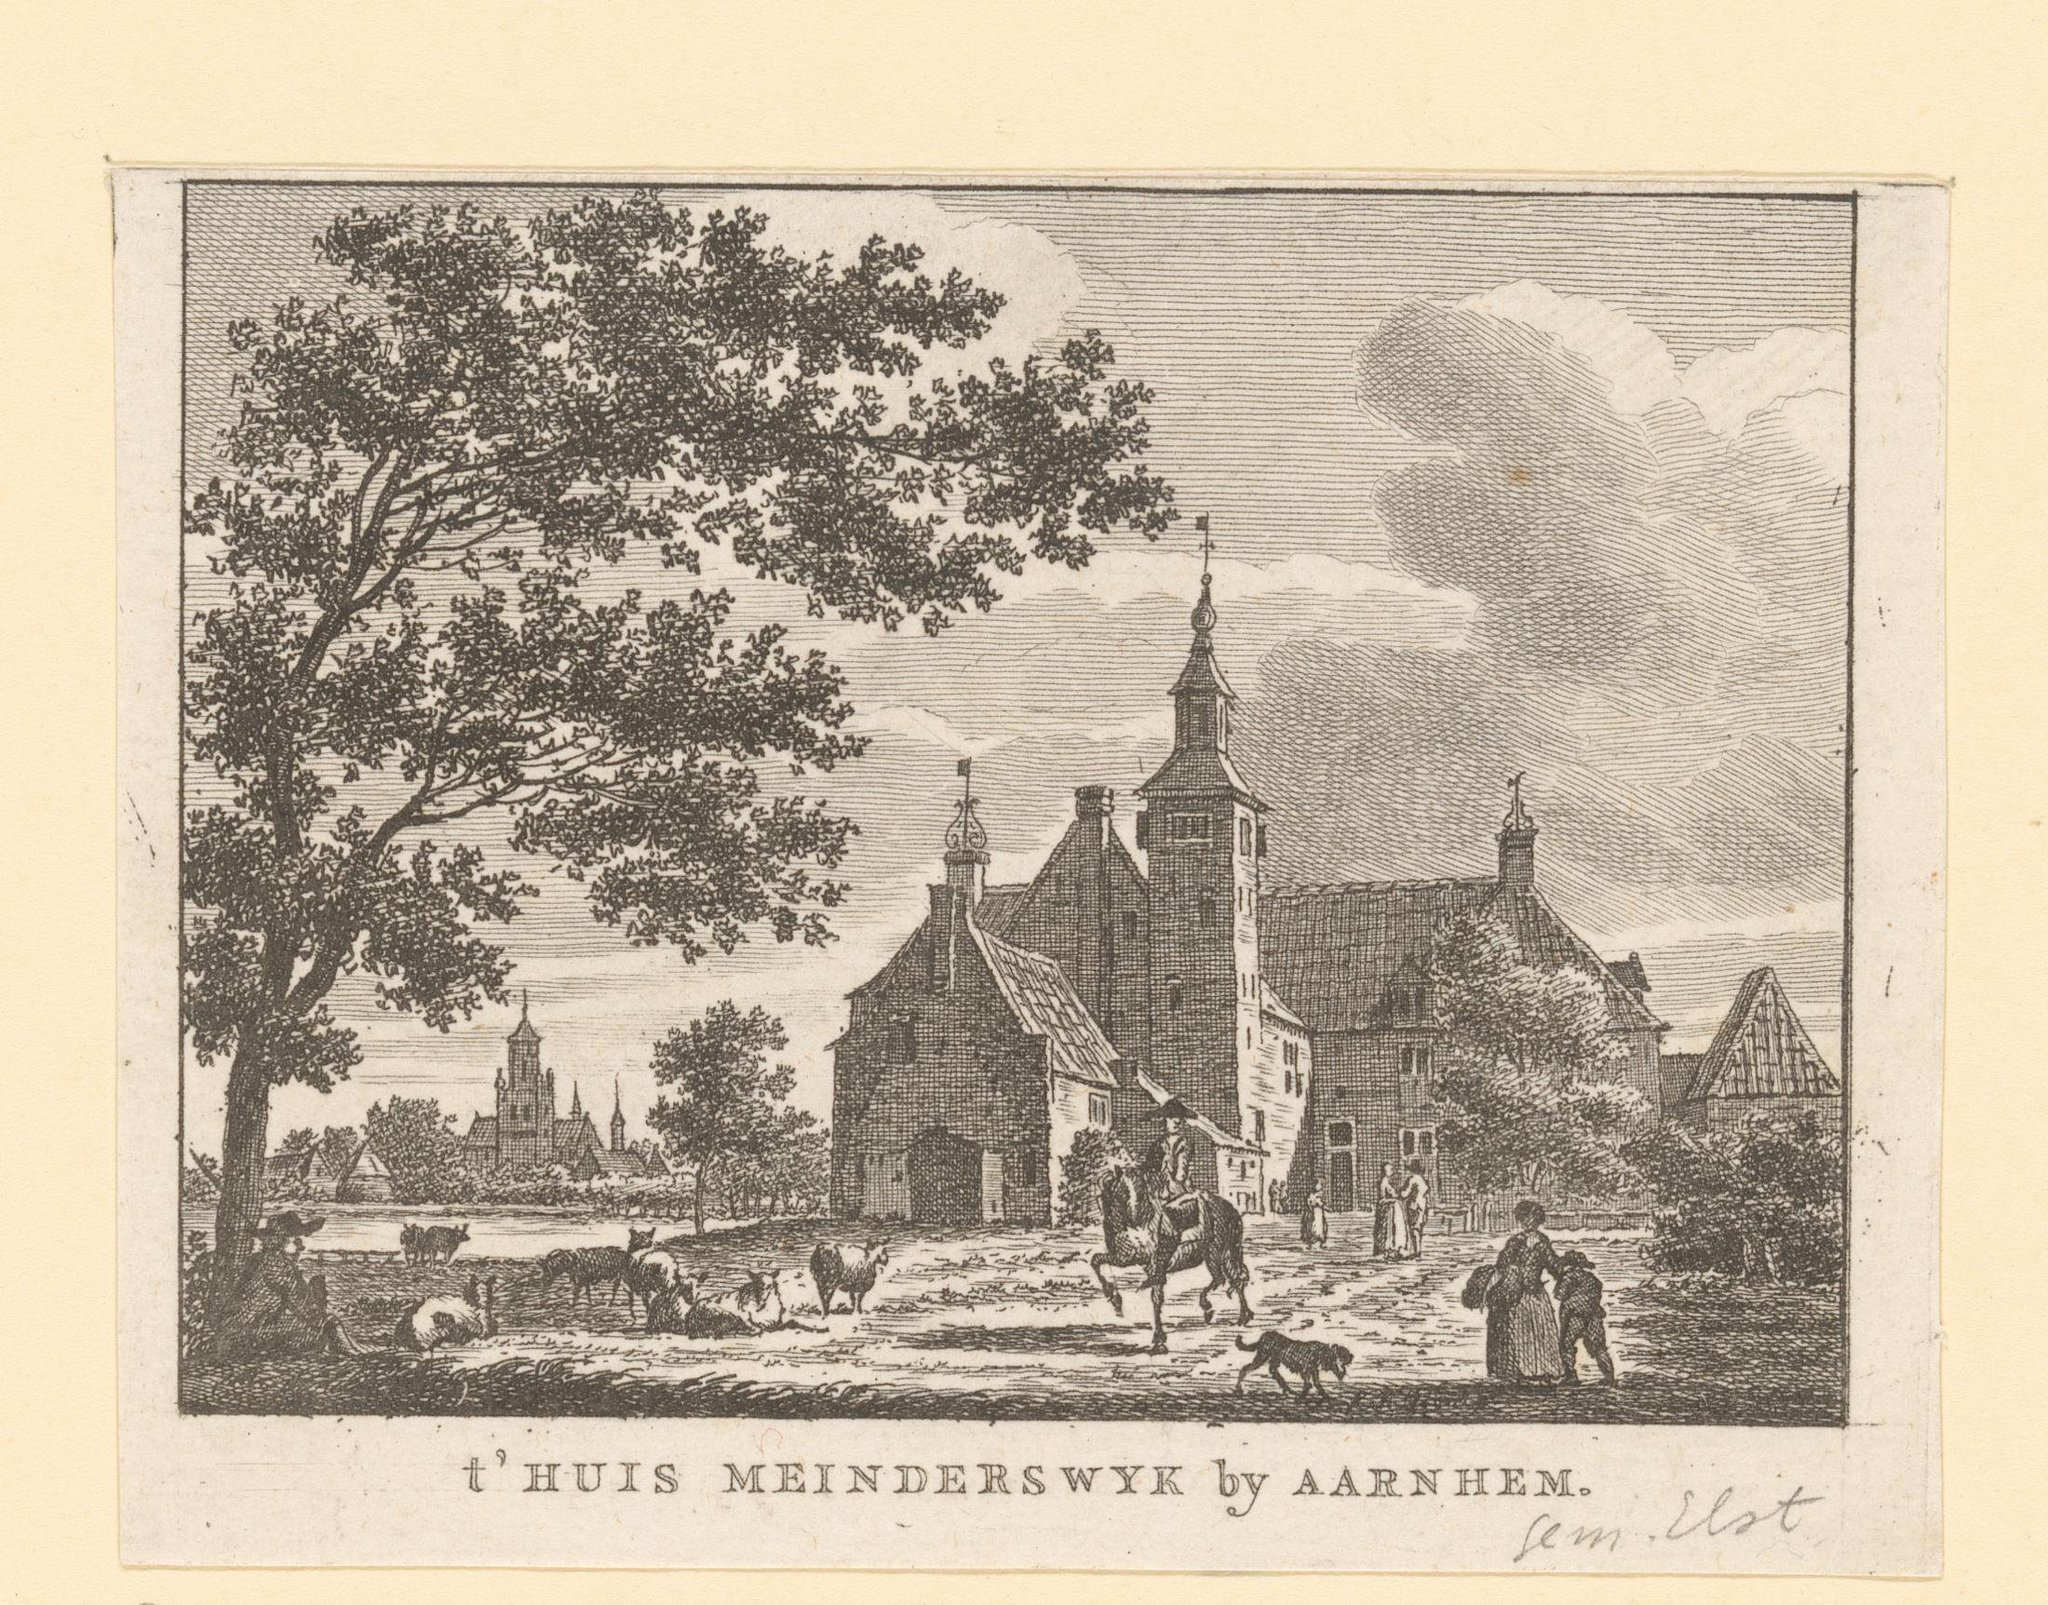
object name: print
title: Gezicht op het Huis Meinerswijk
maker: carel frederik bendorp (i)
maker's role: print maker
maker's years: 1736-1814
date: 1786-1792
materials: paper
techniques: etching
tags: castle, arnhem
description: Prent uit: Vaderlandsche gezichten, of afbeeldingen van den tegenwoordigen staat der Vereenigde Nederlanden (…). Amsterdam: Hendrik Gartman, Willem Vermandel en Jan Willem Smit, 1786-1792. Uitgegeven in afleveringen met ieder een eigen bifolium en inhoudsopgave. Alle prenten in deze publicatie zijn gegraveerd door Carel Frederik Bendorp (I) en, in de meeste gevallen, gebaseerd op tekeningen van Jan Bulthuis.